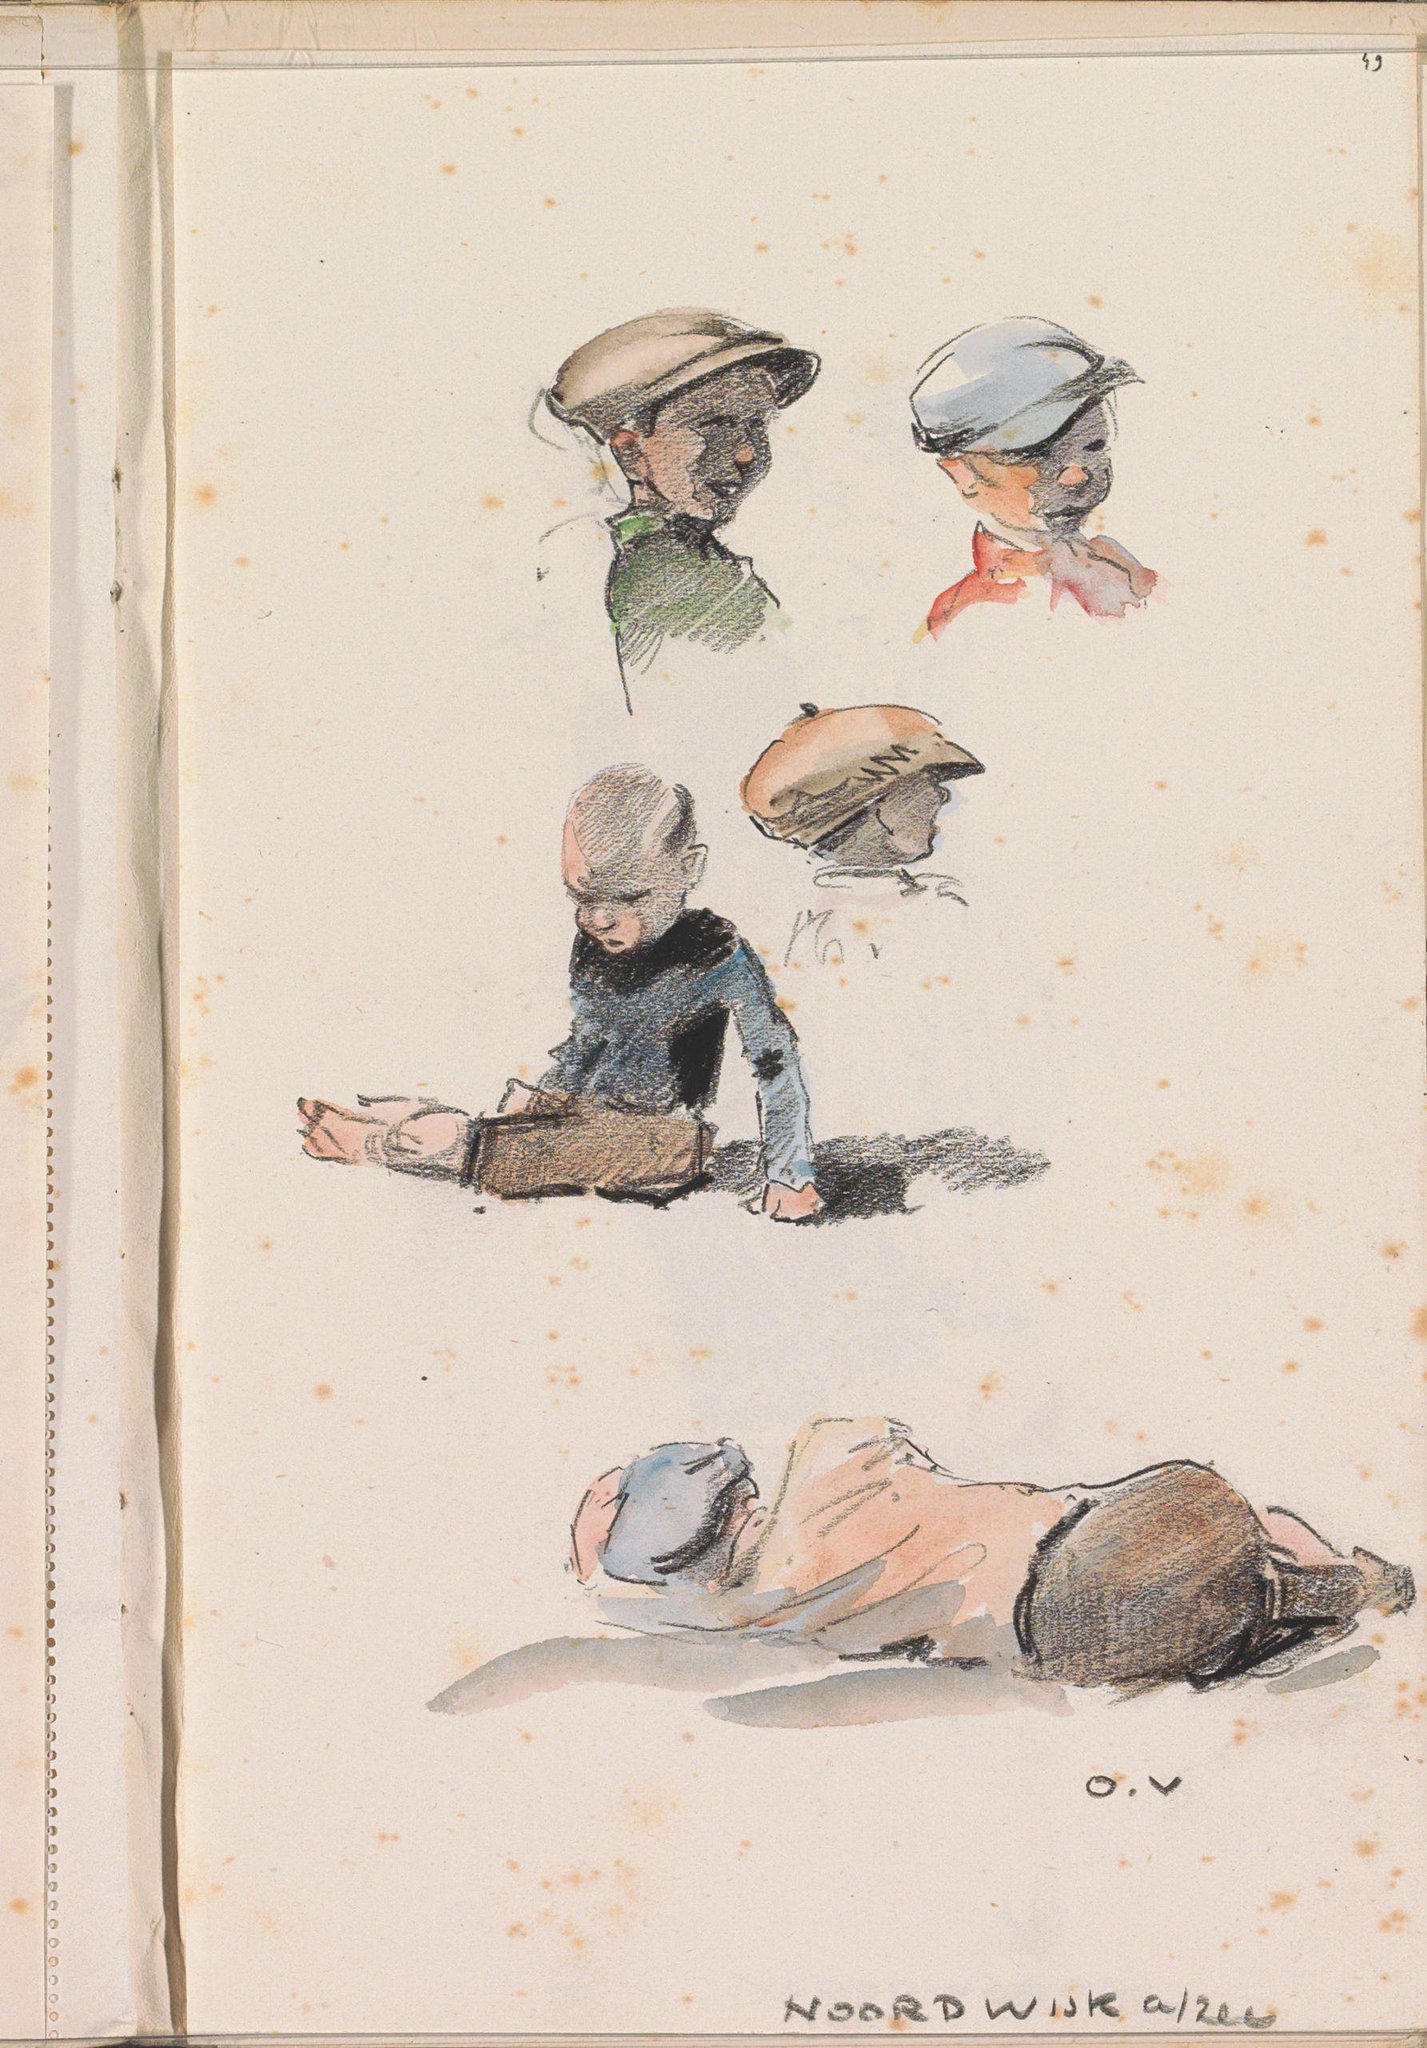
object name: sketchbook leaf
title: Slapend en zittend kind op het strand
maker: otto verhagen (i)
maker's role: draughtsman, print maker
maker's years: 1885-1951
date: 1930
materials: chalk, paper, watercolor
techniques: brush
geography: noordwijk aan zee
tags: boy (child between toddler and youth), sleeping on the ground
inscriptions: annotation: ‘NOORDWIJK a/Zee’, signature: ‘O.V.’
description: Tevens studies van jongens met petten. Pagina 49 uit een schetsboek met 51 bladen.